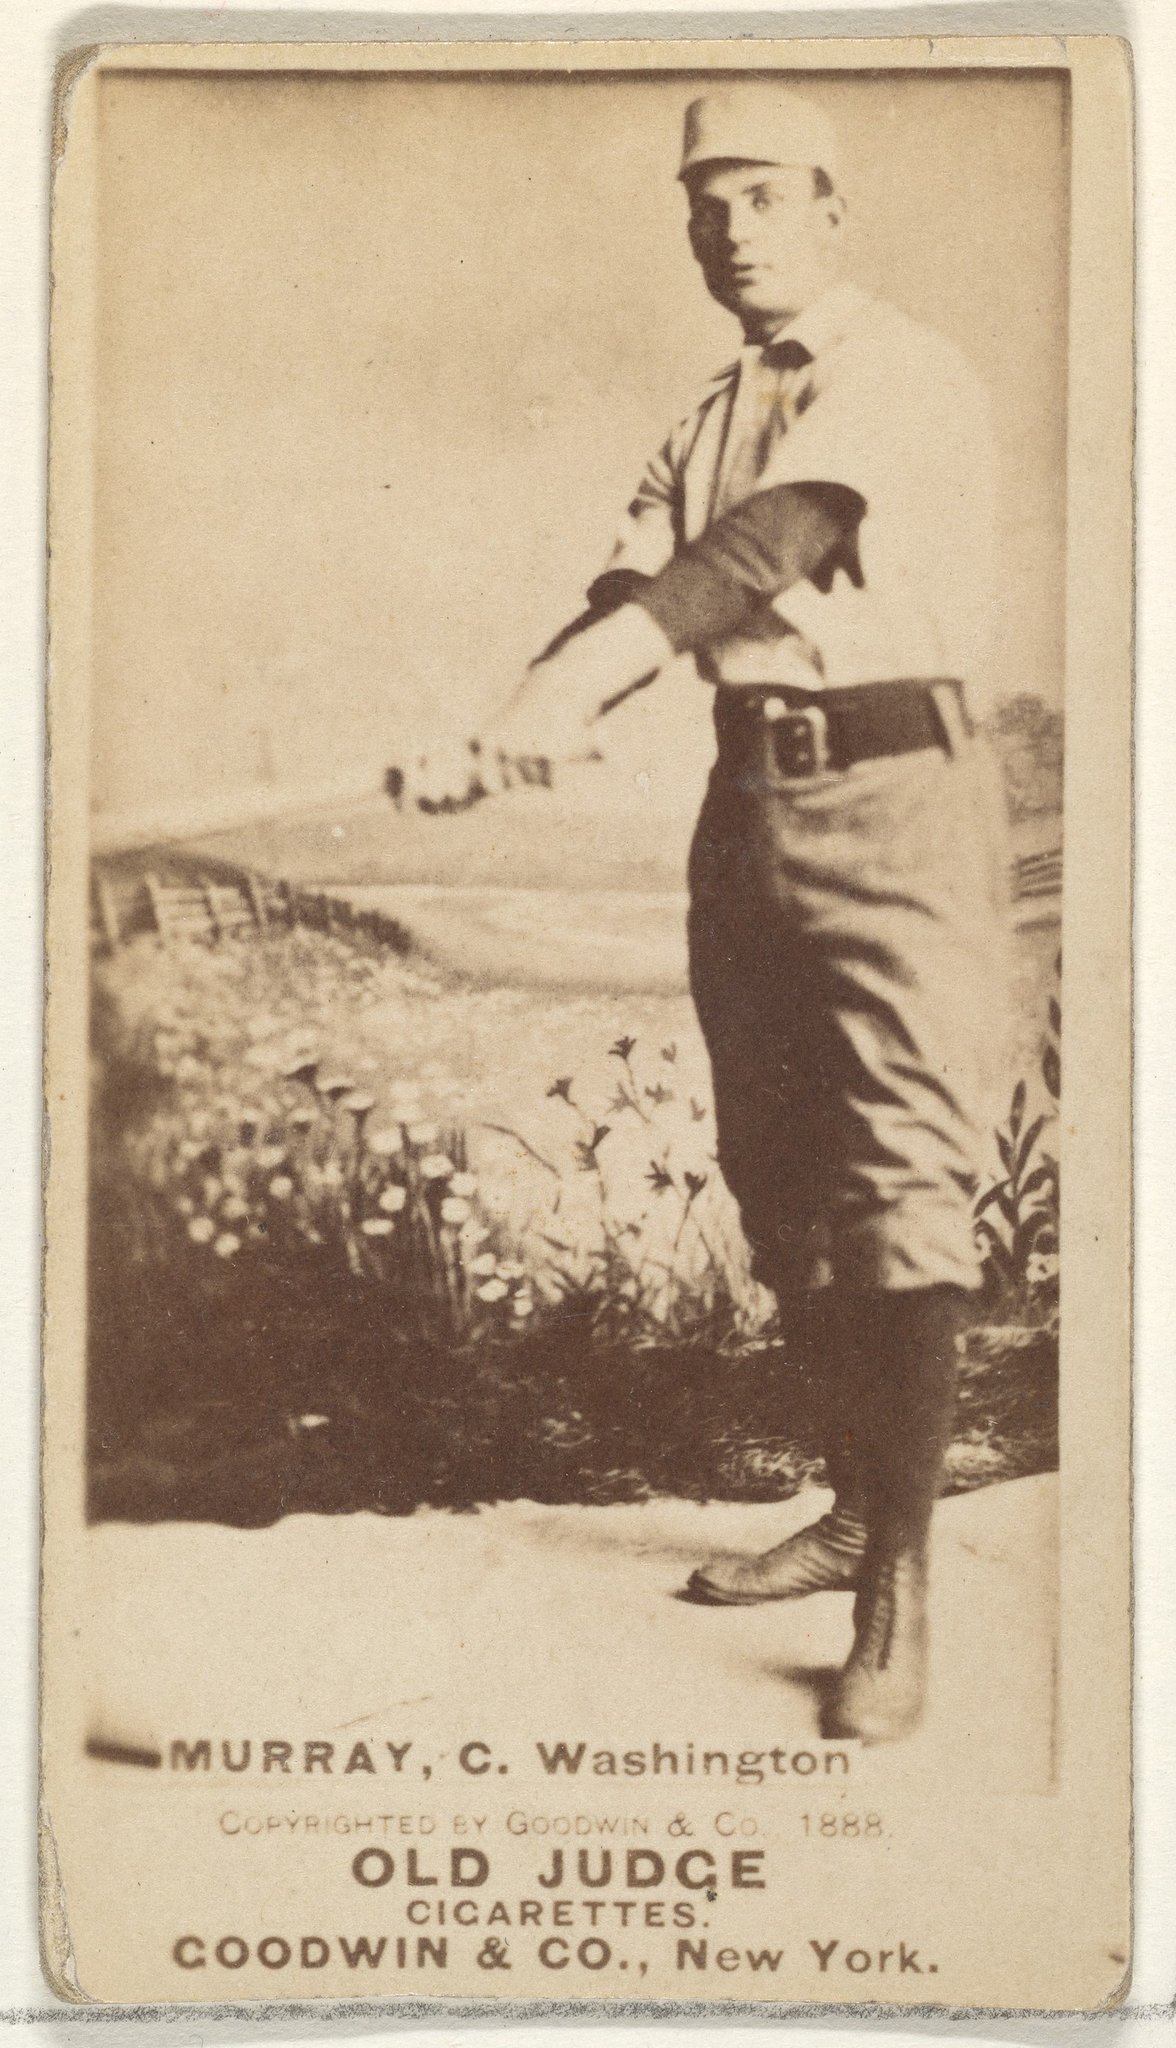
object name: baseball card, photograph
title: Jeremiah J. "Miah" Murray, Catcher, Washington Nationals, from the Old Judge series (N172) for Old Judge Cigarettes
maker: goodwin & company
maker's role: publisher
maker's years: 1850-1950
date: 1888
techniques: albumen silver print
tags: men,portraits,baseball,athletes